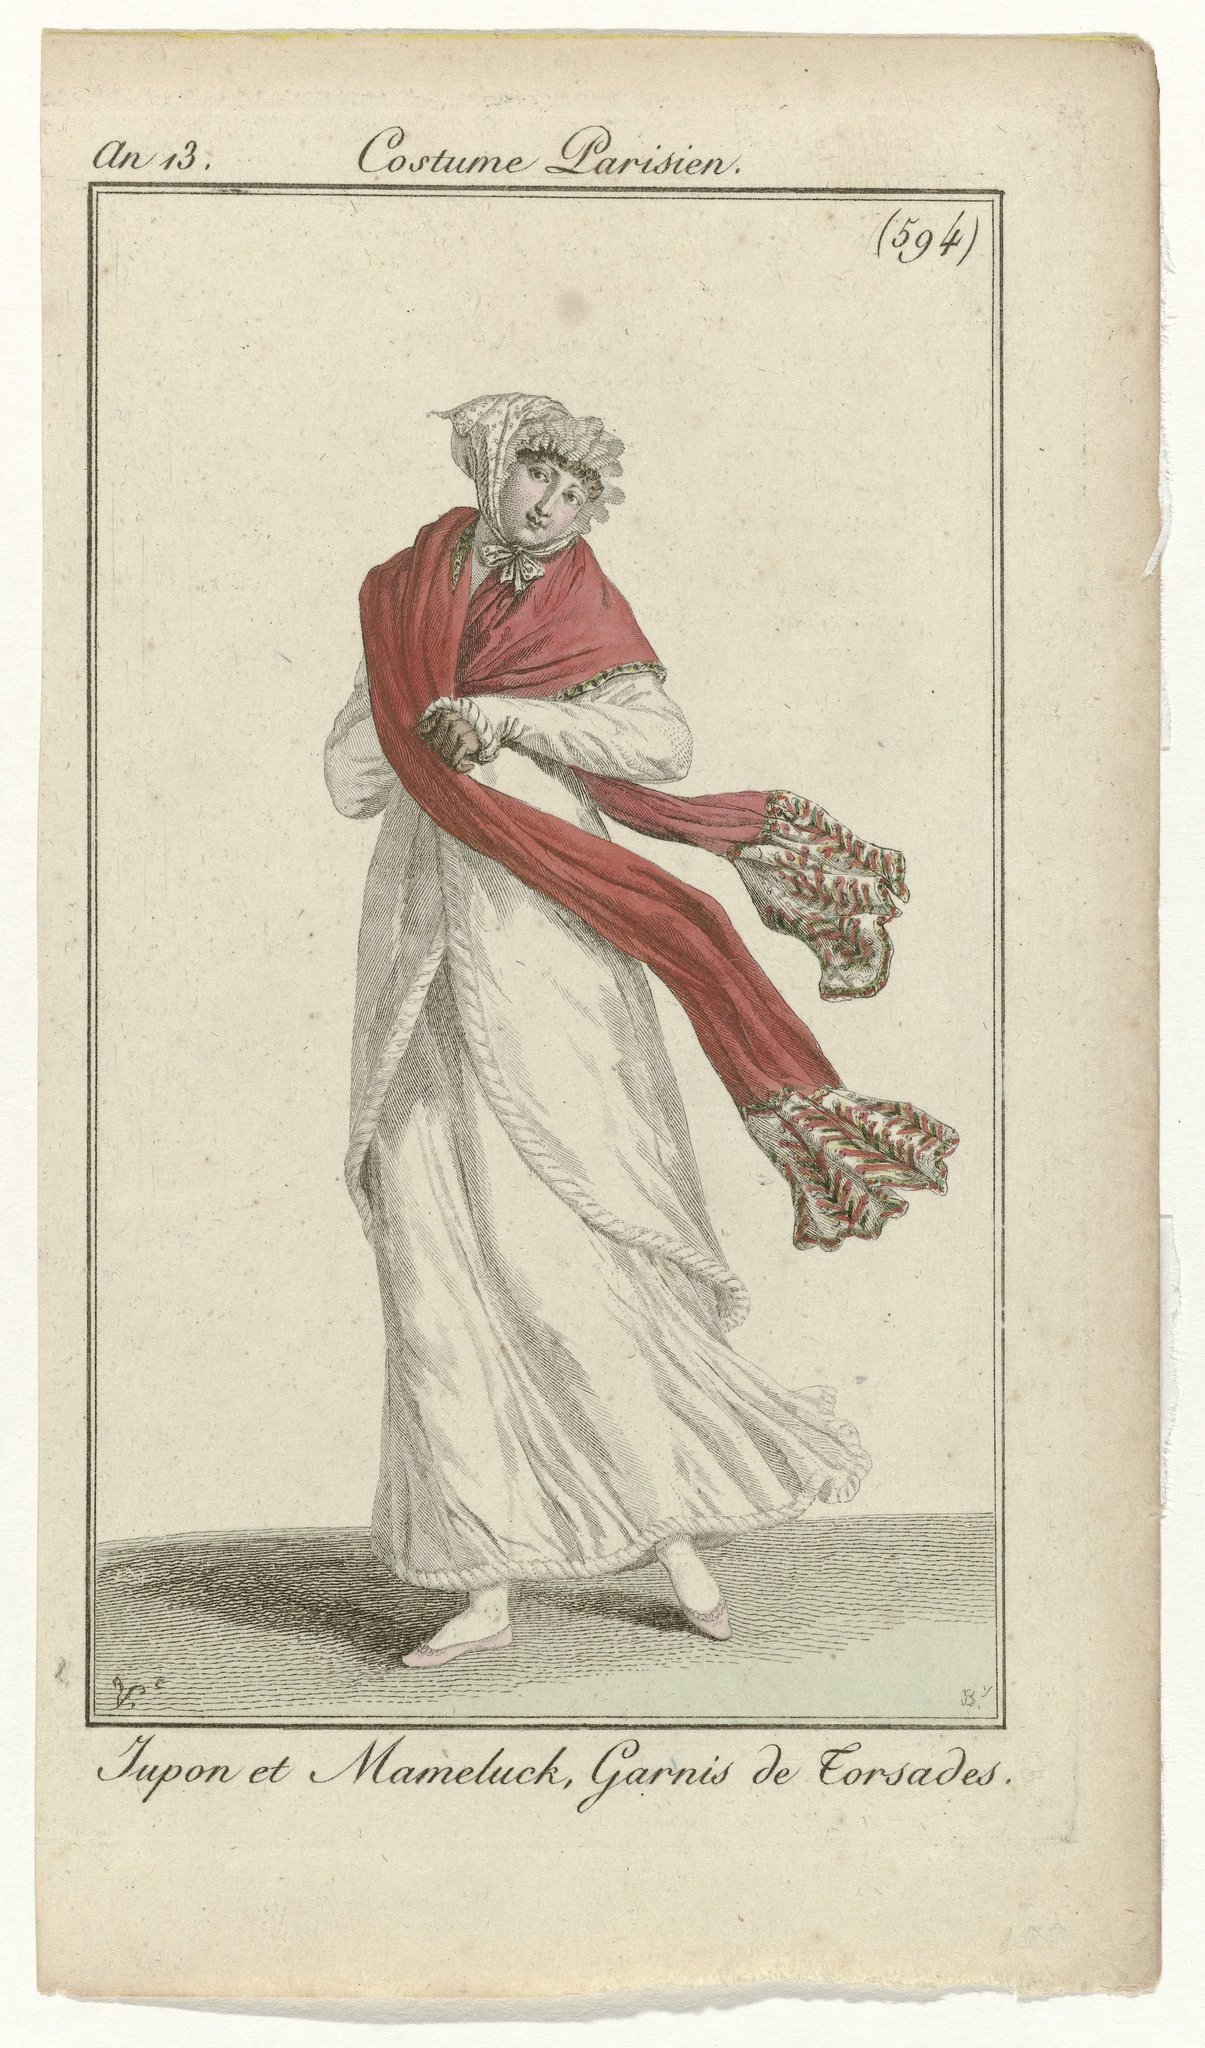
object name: fashion print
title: Journal des Dames et des Modes, Costume Parisien, 6 novembre 1804, An 13, (594): Jupon et Mameluck (...)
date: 1804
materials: paper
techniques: engraving, hand coloring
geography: paris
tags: clothing for the upper part of the body (shawl) (+ women's clothes), border, ribbon, braid (+ women's clothes), dress, gown (tunic) (+ women's clothes), head-gear: cap (+ women's clothes), fashion plates, shoes, sandals (+ women's clothes), skirt (+ women's clothes), gloves, mittens, etc. (+ women's clothes)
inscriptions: caption: ‘Jupon et Mameluck, Garnis de Torsades.’, title: ‘Costume Parisien.’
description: Vrouw in een rok en tuniek 'Mameluck' versierd met 'torsades'. Op het hoofd een muts waarover een fichu(?) is geknoopt. Verdere accessoires: lange sjaal bij de utieinden versierd met bladmotief, handschoen, platte schoenen. De prent maakt deel uit van het modetijdschrift Journal des Dames et des Modes, uitgegeven door Pierre de la Mésangère, Parijs, 1797-1839.